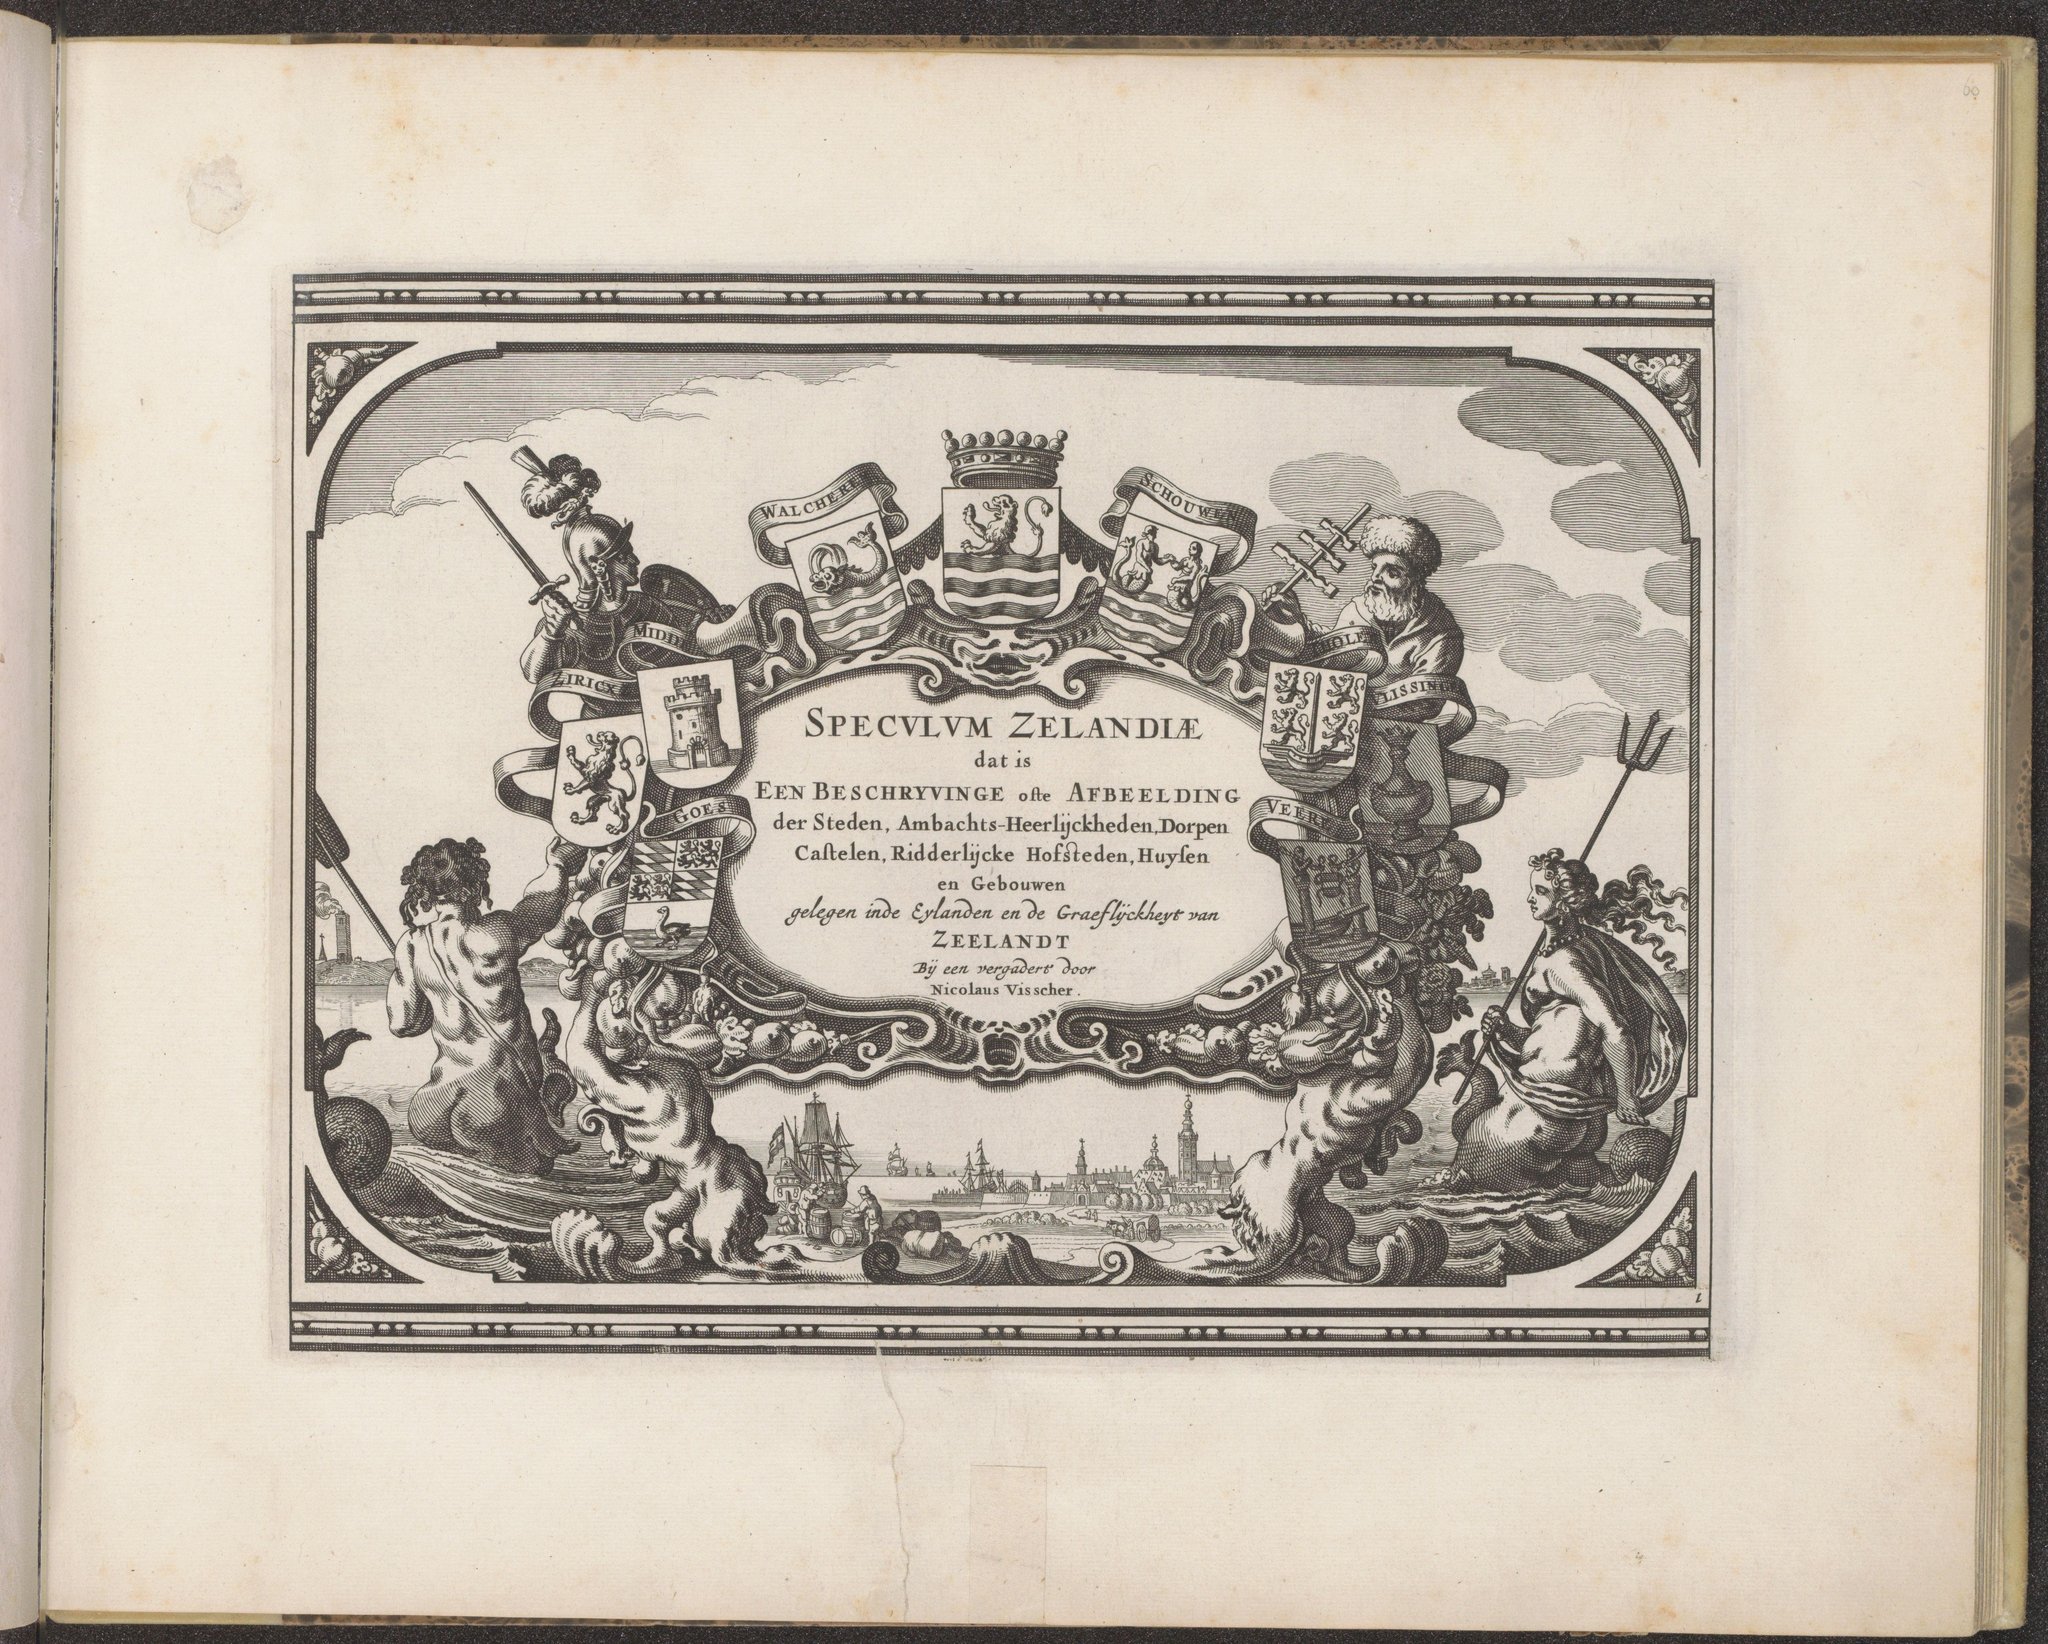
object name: titelprent, frontispice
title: Titelprent voor een serie stadsgezichten, kastelen, hofsteden en buitenplaatsen in Zeeland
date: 1662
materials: paper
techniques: etching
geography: amsterdam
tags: coat of arms (as symbol of the state, etc.), city-view, and landscape with man-made constructions, title-page, seaman, ornament ~ cartouche, knight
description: Cartouche met de titel van de serie gedragen door de zee. Bovenop het wapen van Zeeland en de wapens van de belangrijkste steden in de provincie. Daarbij een ridder en een zeeman. De cartouche wordt geflankeerd door een man en vrouw met vissenstaart en in hun hand een peddel en drietand. Onderaan een stadsgezicht. De prent maakt deel uit van een album.